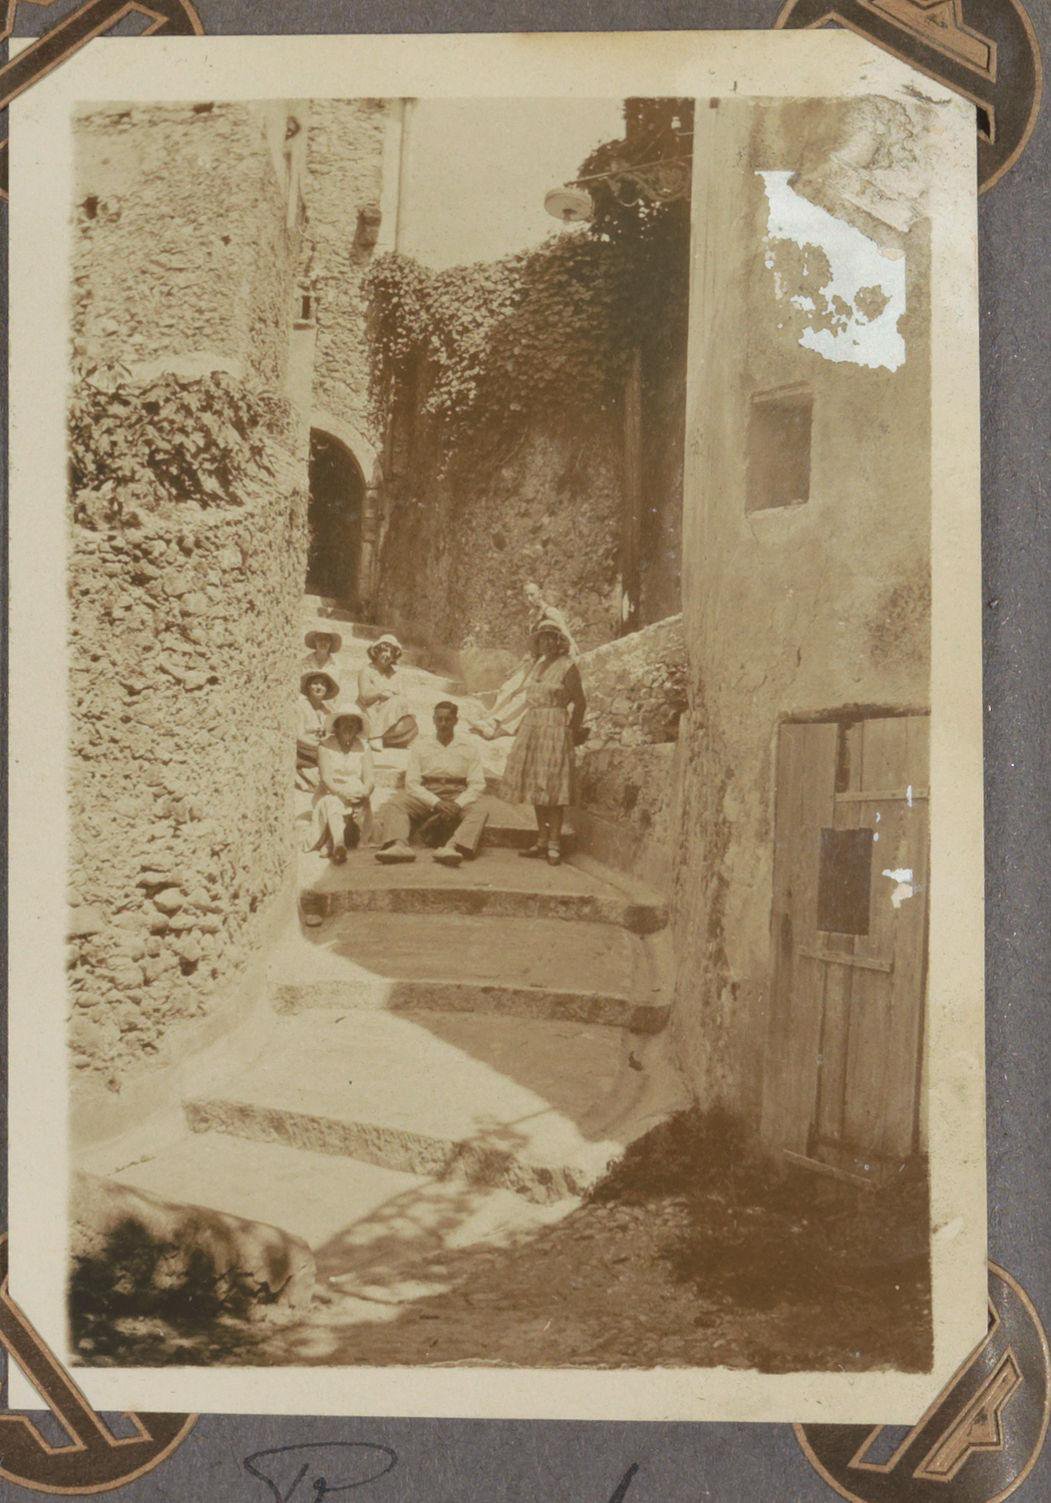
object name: photograph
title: Gezelschap zittend op de trappen van een straat in Roquebrune-Cap-Martin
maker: Anonymous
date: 1930-1935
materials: photographic support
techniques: gelatin silver print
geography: roquebrune-cap-martin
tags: adult woman, sloping street; street with steps or stairs, adult man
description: Onderdeel van Fotoalbum met opnames van vakanties in Zuid-Frankrijk.